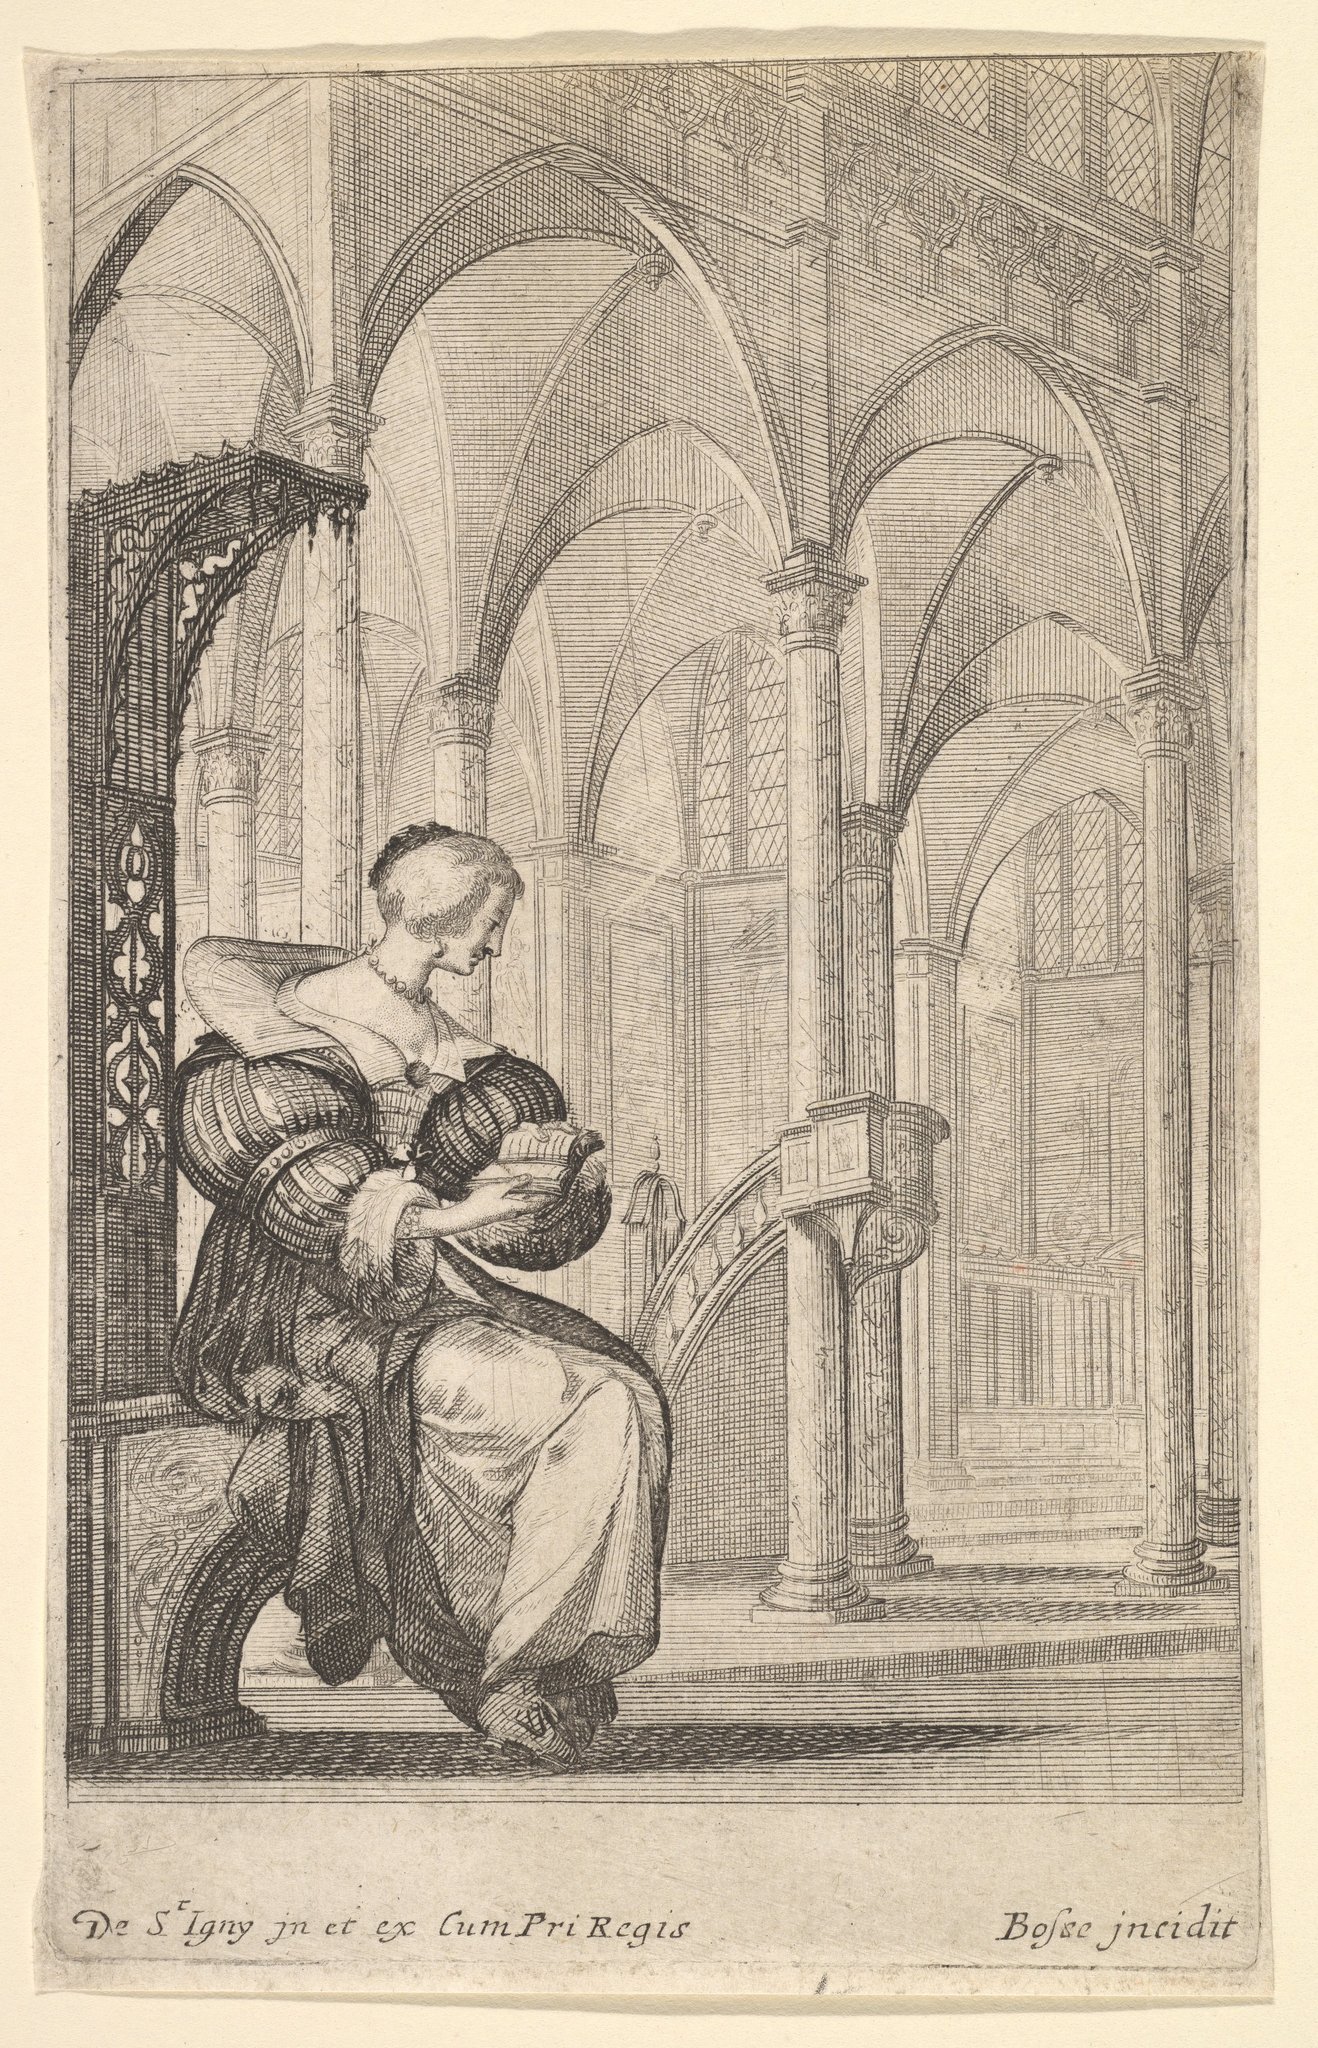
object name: print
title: A Seated Lady, from "French Nobility at Church"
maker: abraham bosse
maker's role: artist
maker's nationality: french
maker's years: 1602-1676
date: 1629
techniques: etching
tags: interiors,women